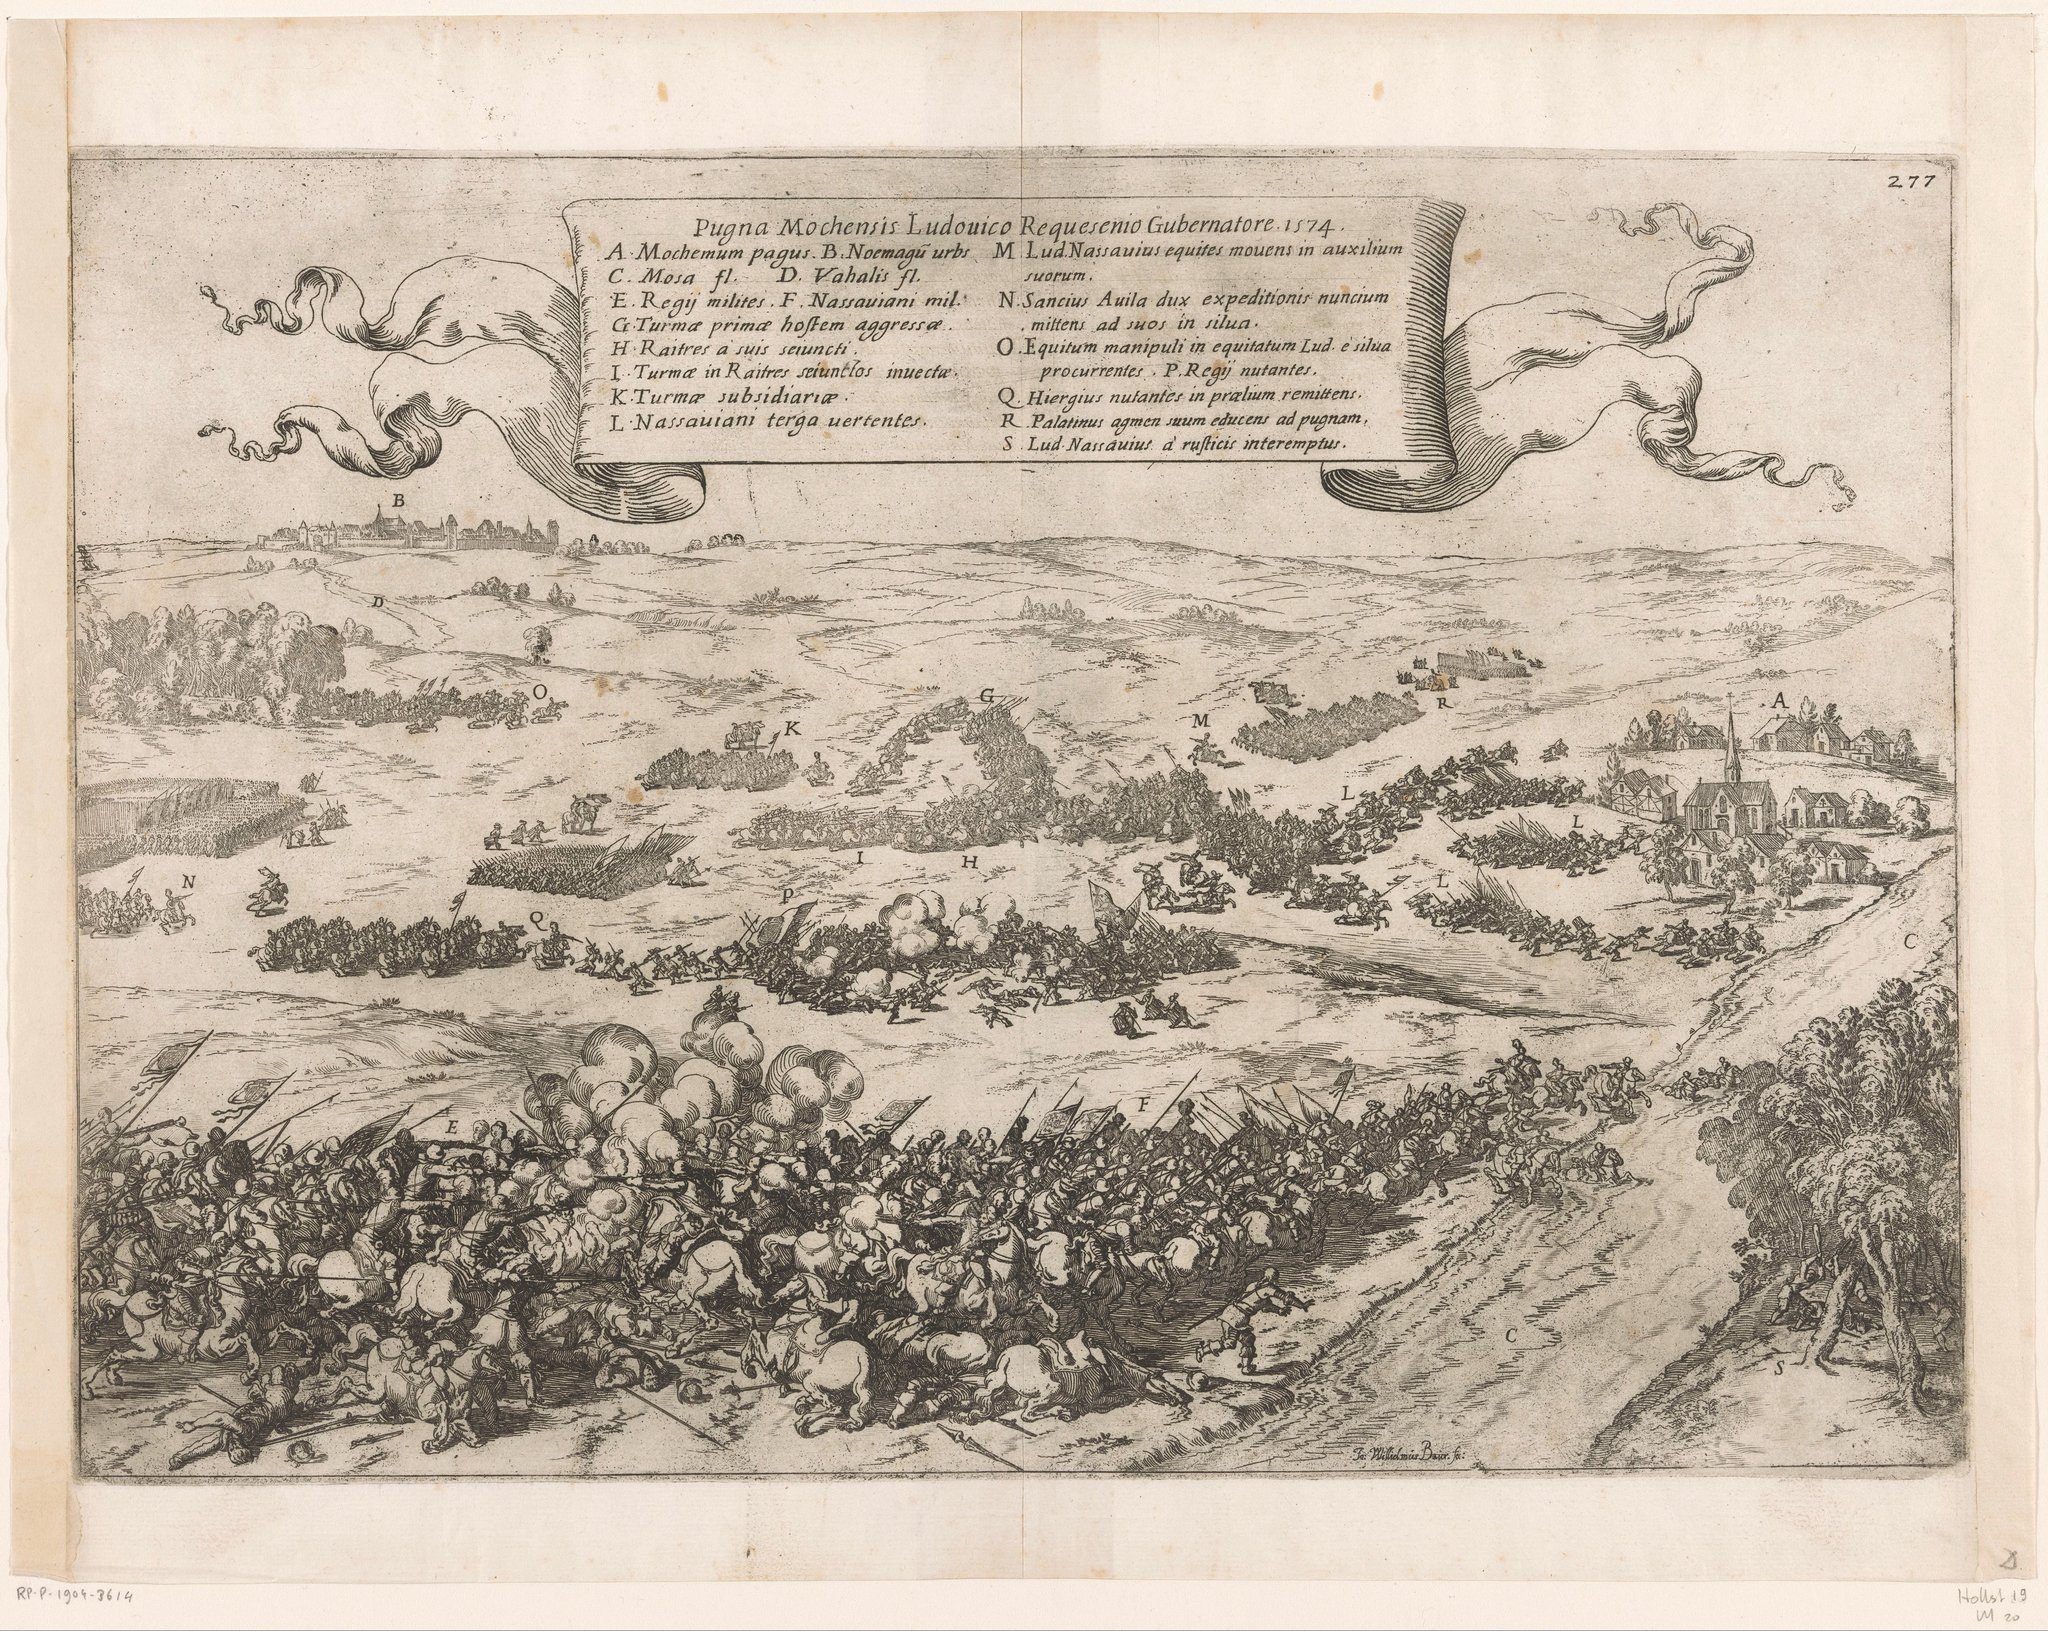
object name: history print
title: Slag op de Mookerheide, 1574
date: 1632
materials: paper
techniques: etching, intaglio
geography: rome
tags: siege, position war, nijmegen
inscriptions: collector's mark: Lugt 2228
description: Slag op de Mookerheide op 14 april 1574. Op de voorgrond en in het midden zware gevechten tussen ruiters. Rechts het dorpje Mook, links in de verte Nijmegen. Bovenin een banderol met de titel en legenda A-S in het Latijn. Rechtsboven genummerd: 277.